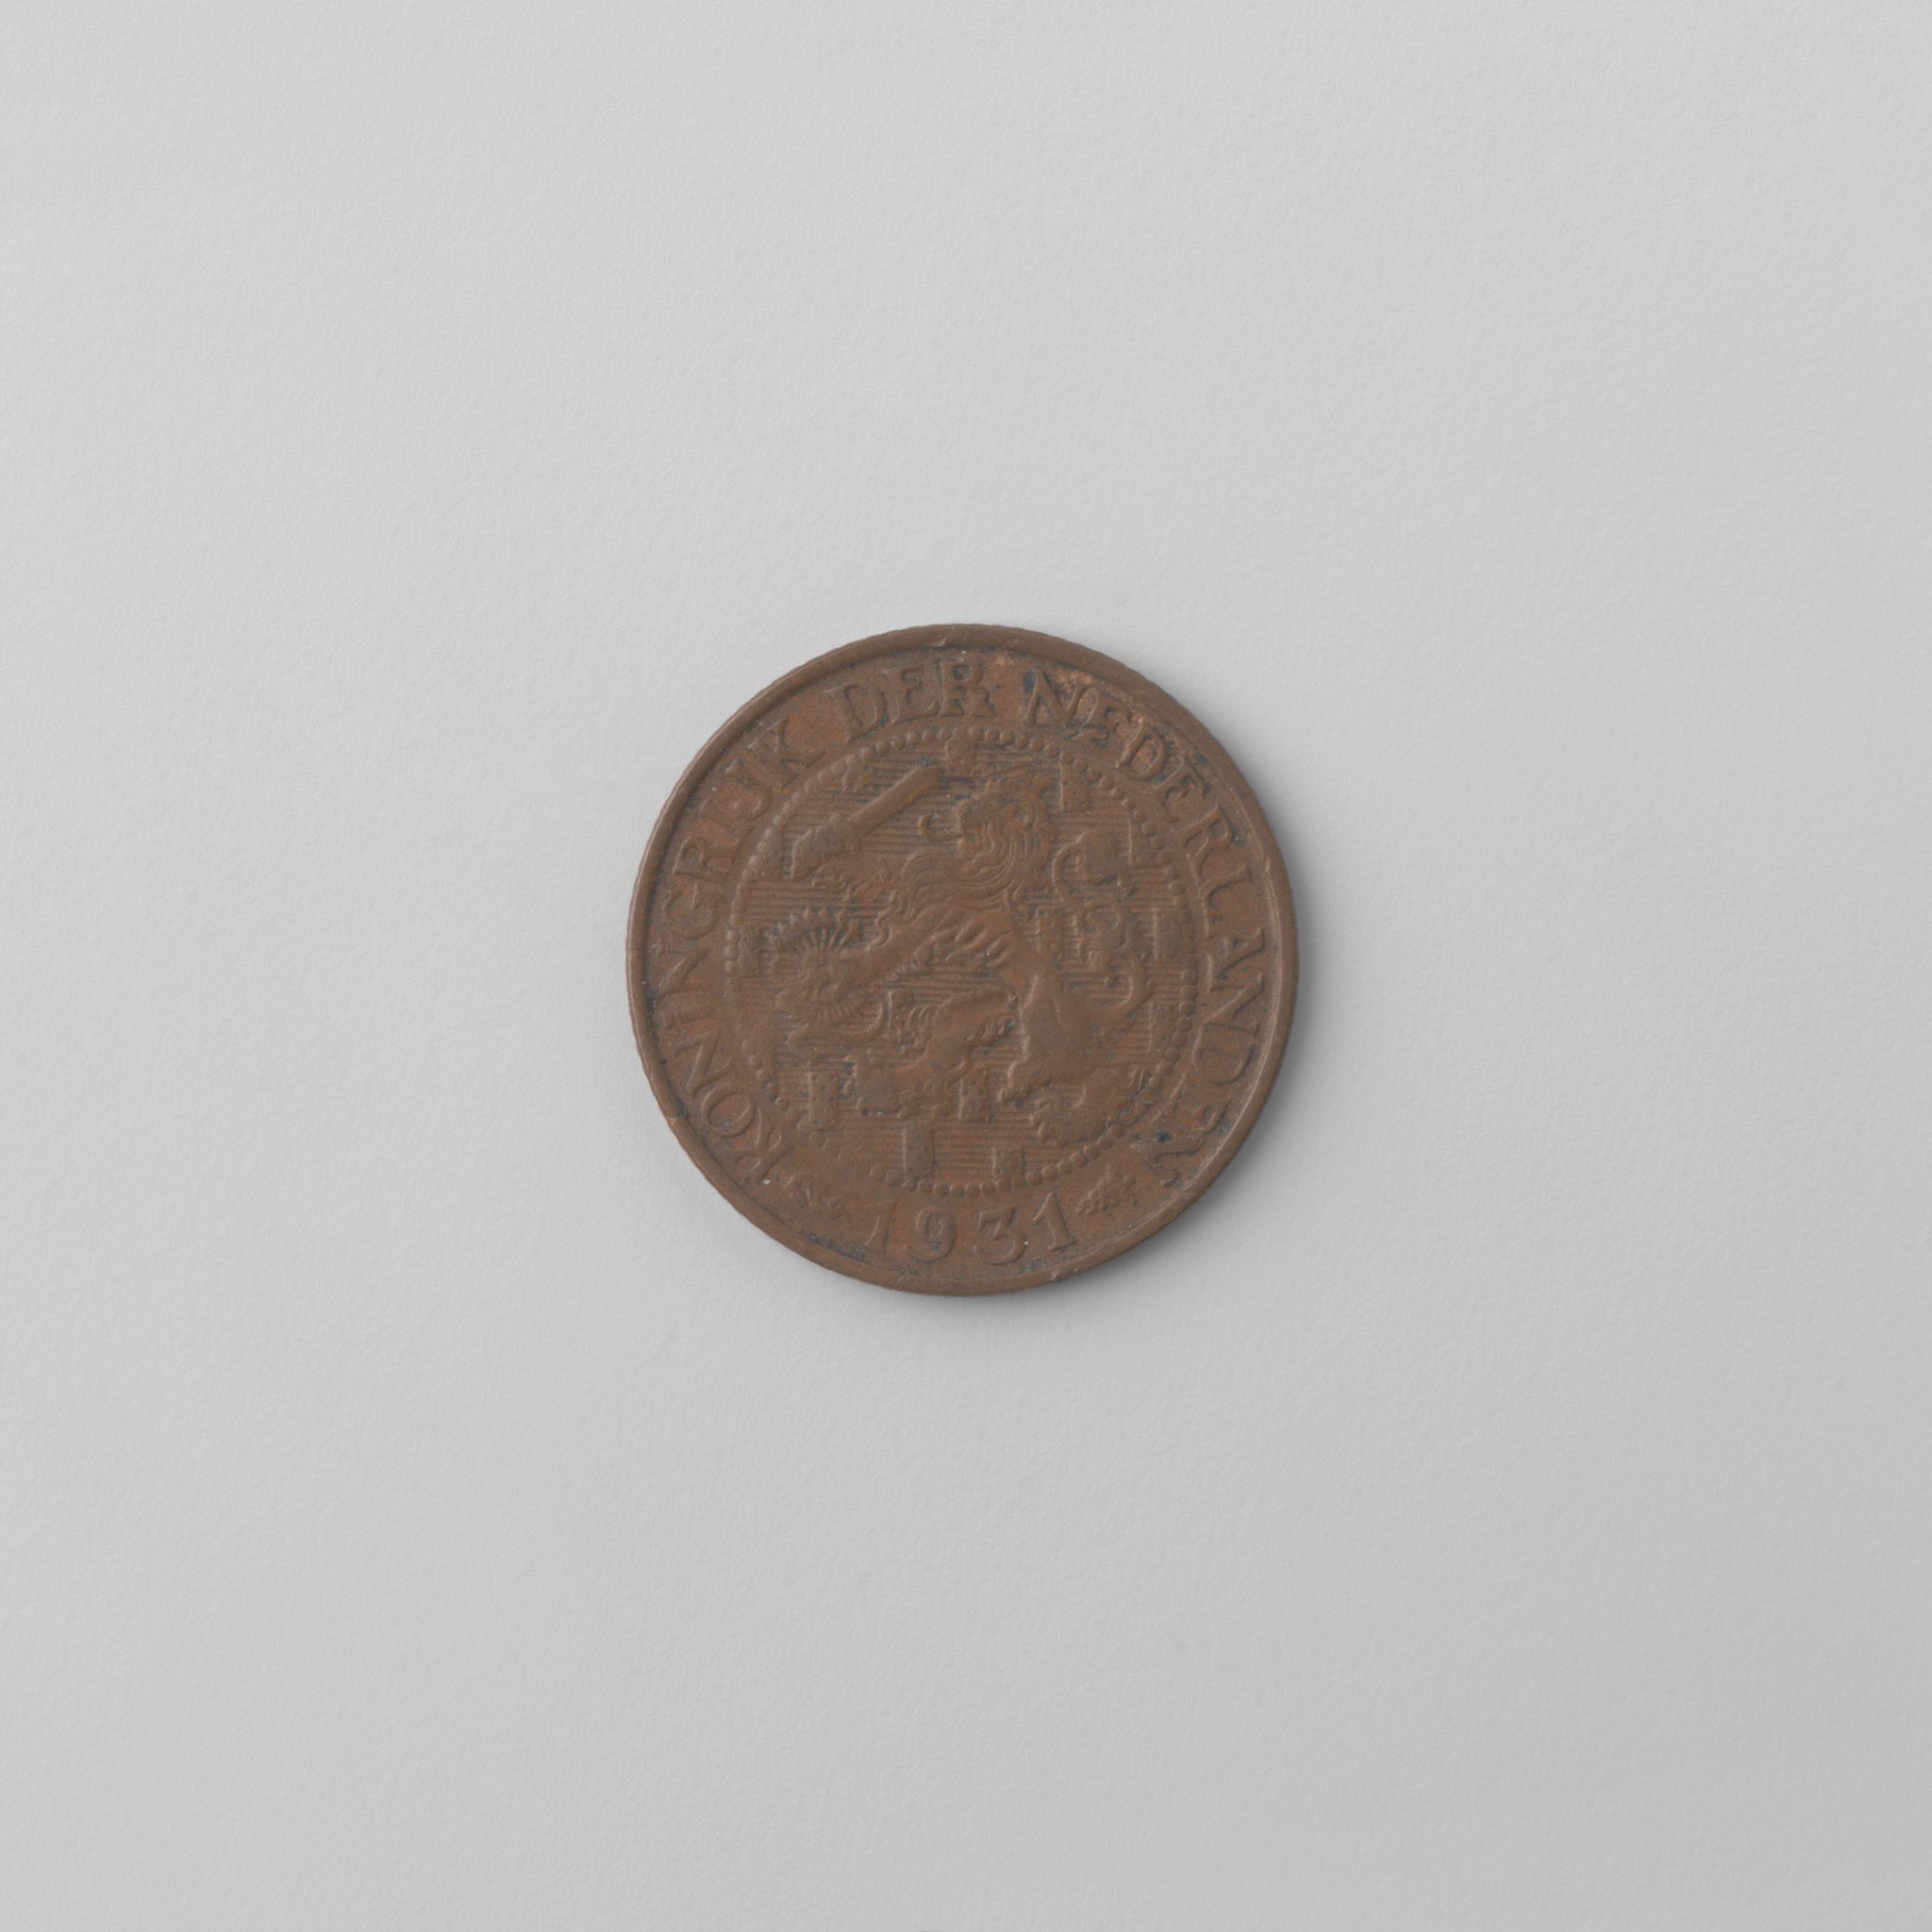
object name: coin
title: Nederlandse cent,1931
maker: wilhelmina of the netherlands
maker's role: print maker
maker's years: 1880-1962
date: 1931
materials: bronze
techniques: striking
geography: utrecht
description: Bronzen munt. Voorzijde: in een veld rijkswapen. Jaartal onderaan in omschrift. Keerzijde: binnen twee samengebonden oranjetakken waarde-aanduiding 1 cent. Kartelrand.